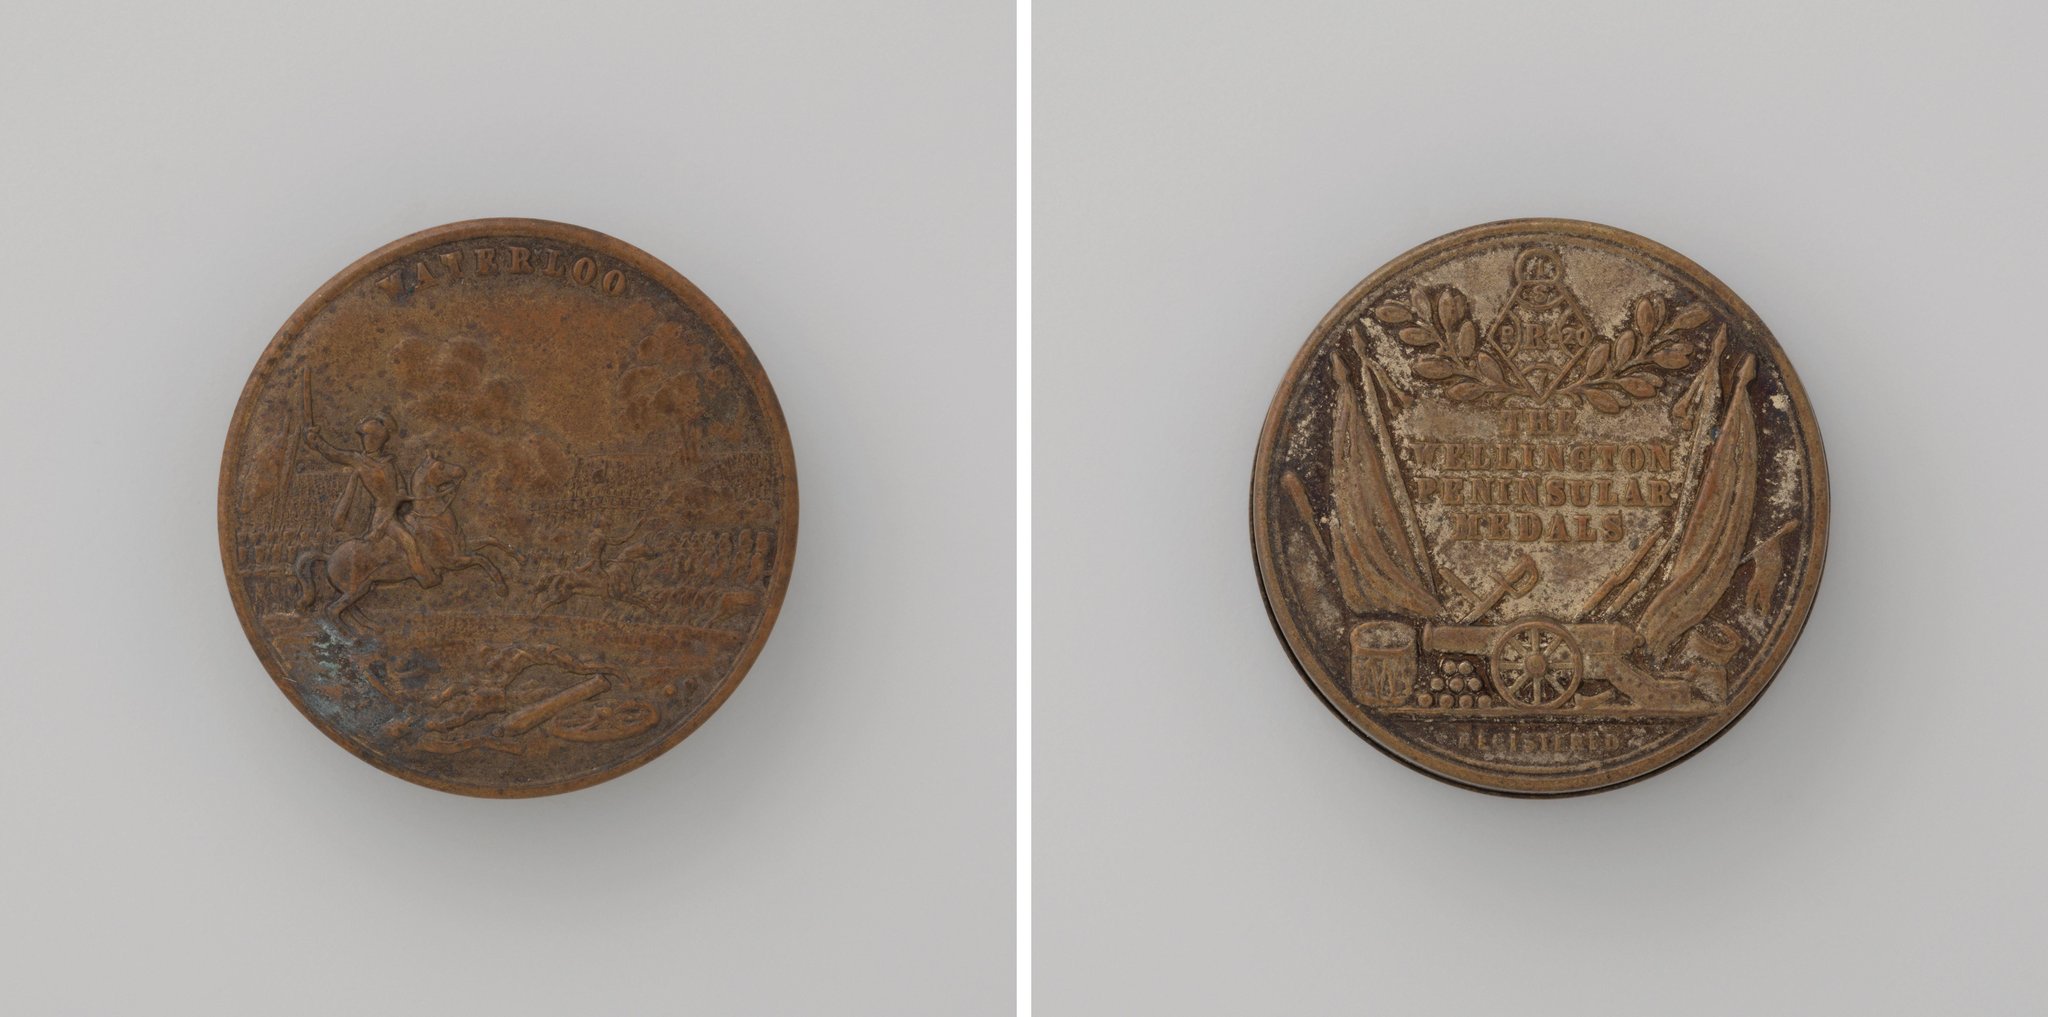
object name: history medal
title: Overwinningen van de geallieerden in de oorlog in Spanje en Portugal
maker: Anonymous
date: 1815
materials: silver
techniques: striking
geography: england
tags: walmer castle, arthur wellesley of wellington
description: Zilveren penning. Voorzijde: ruiters te paard met op achtergrond leger binnen omschrift. Keerzijde: opschrift